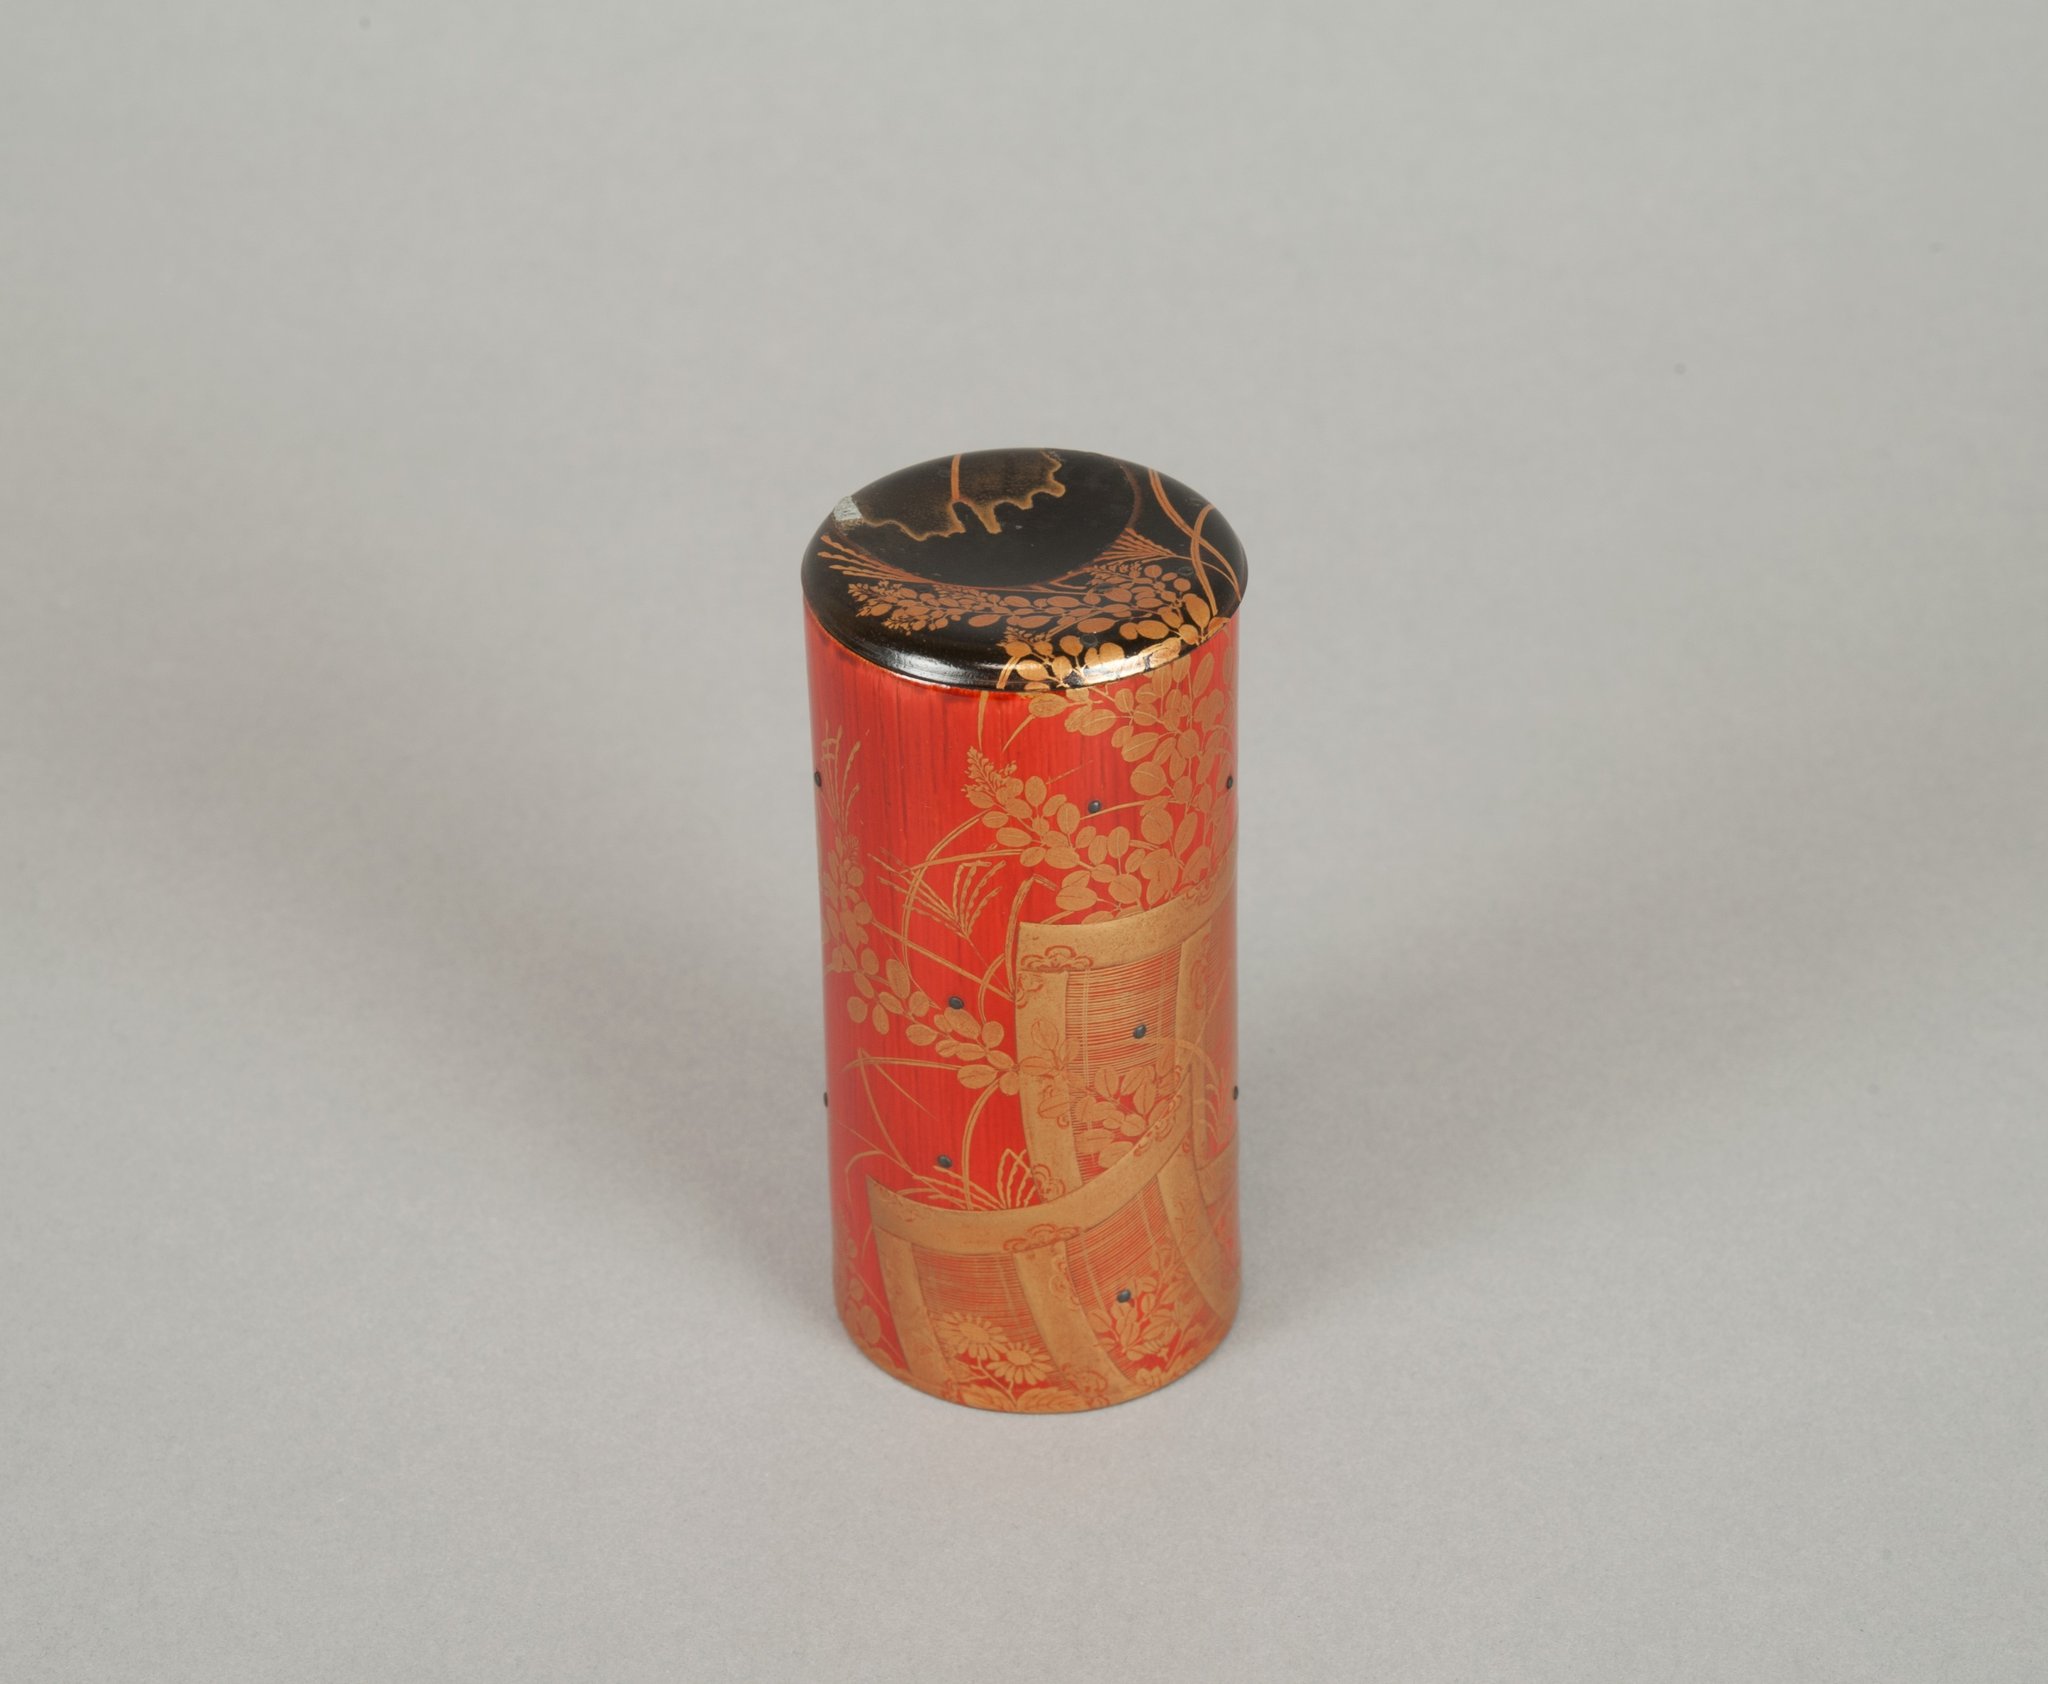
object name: box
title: Cylindrical box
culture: japanese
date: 1801-1900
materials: bamboo, gold, lacquer